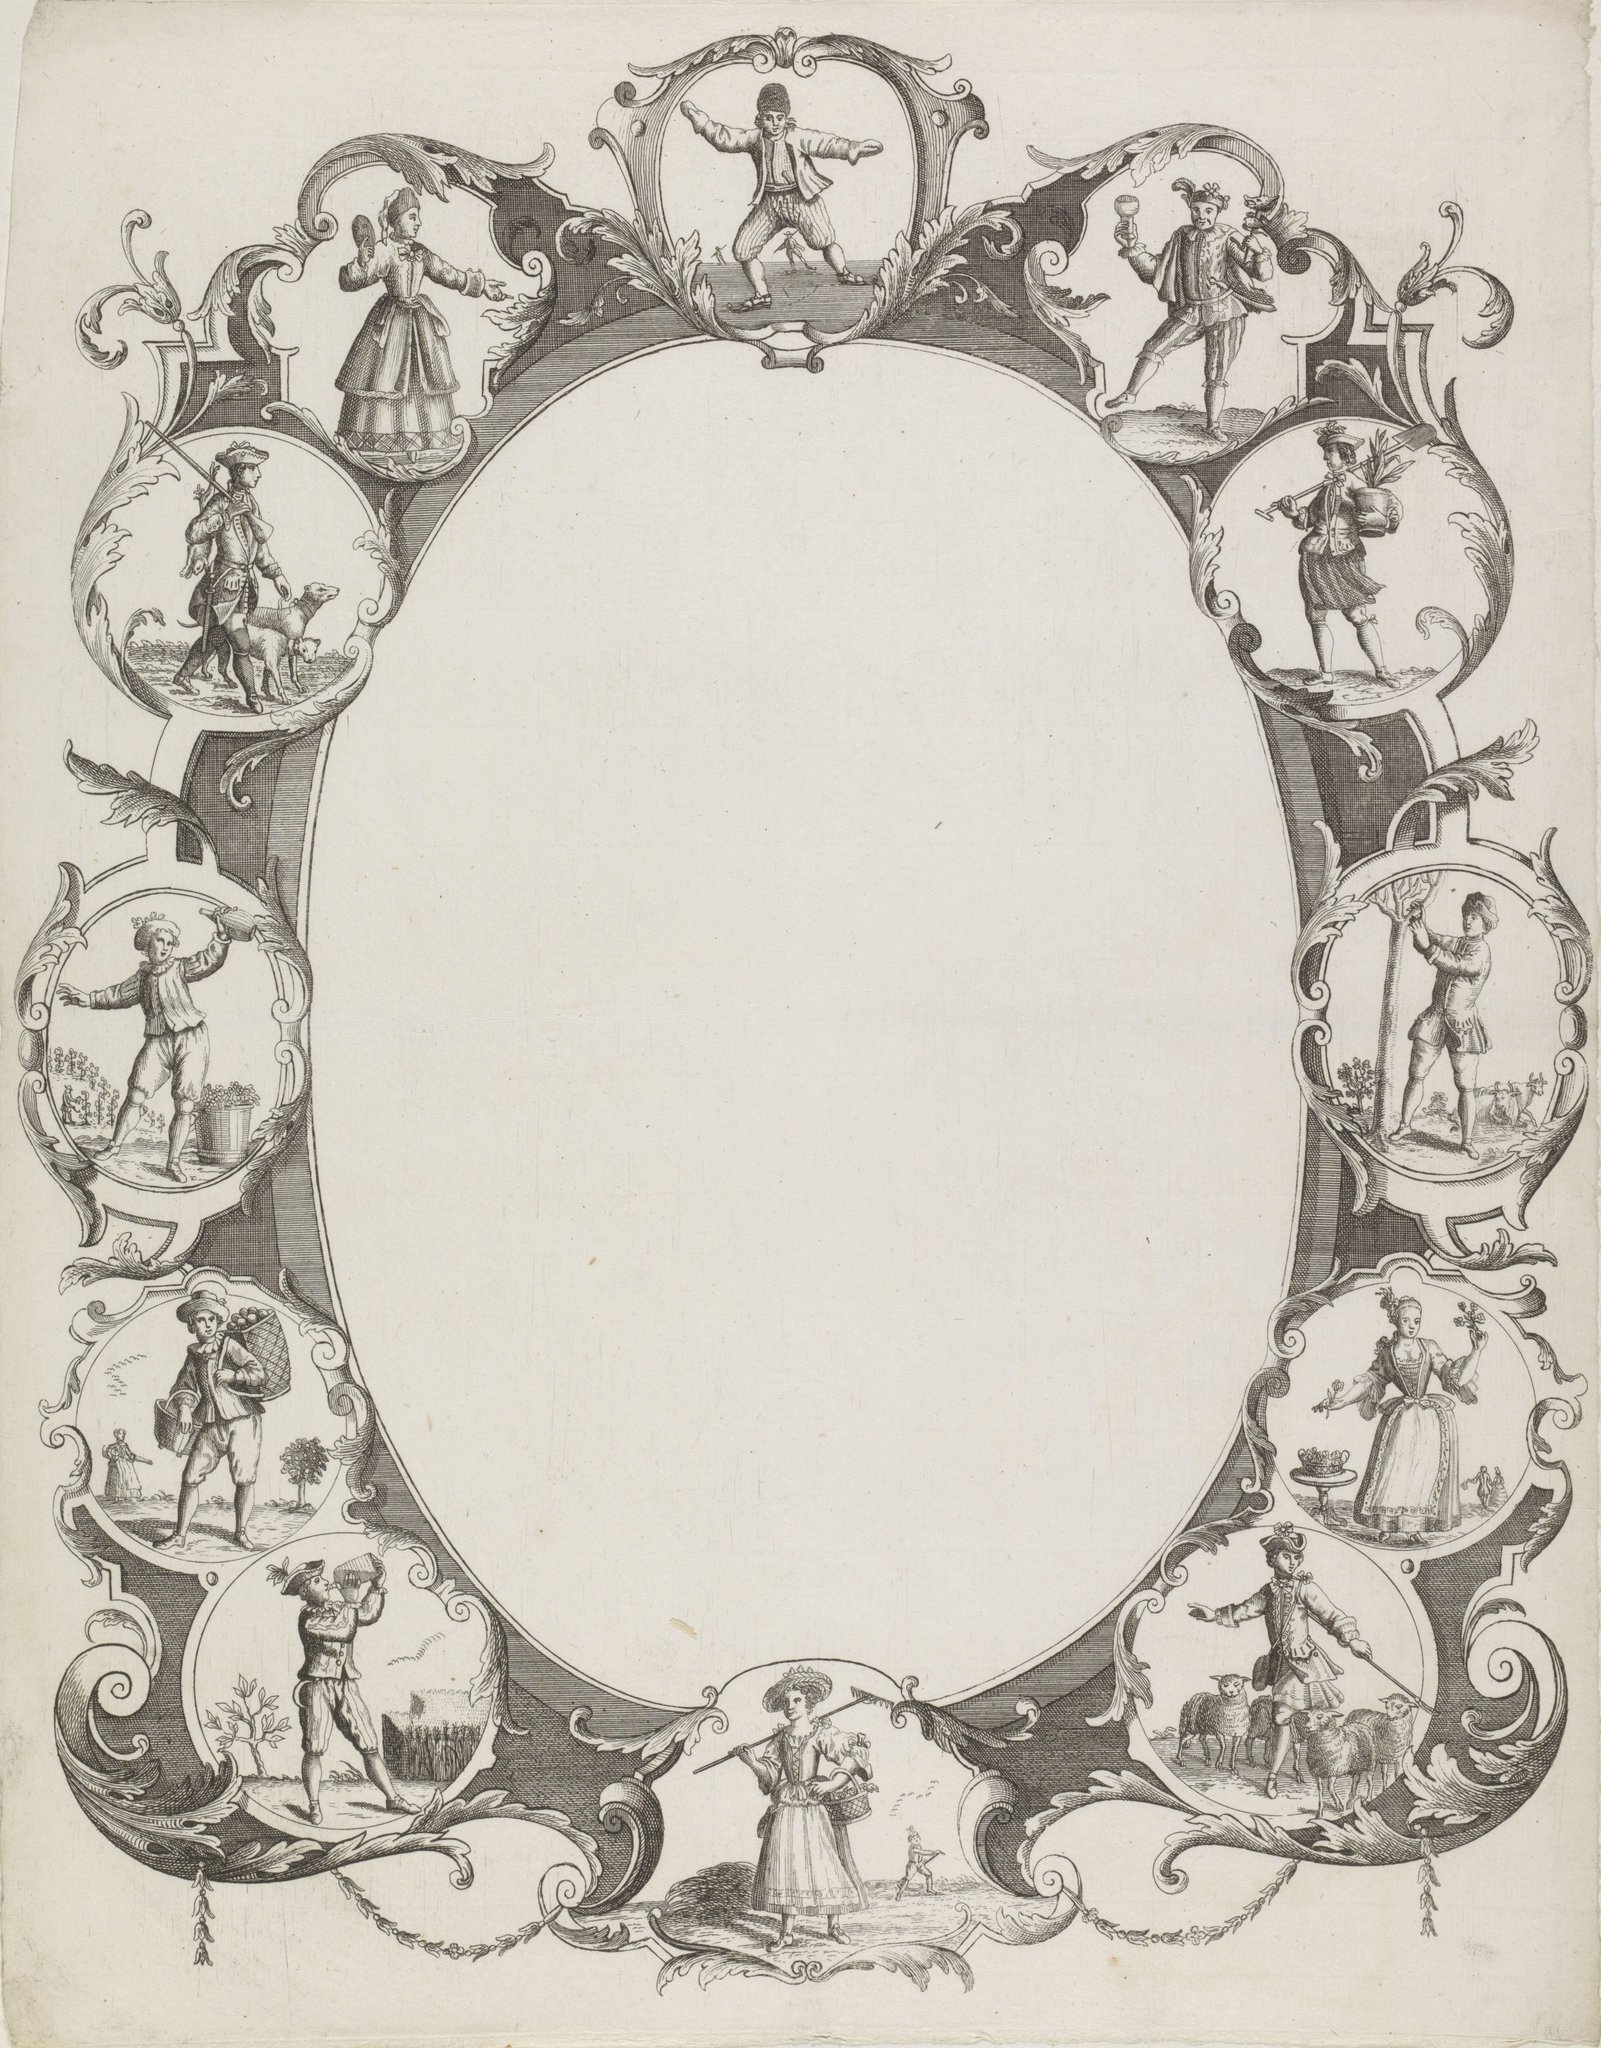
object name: popular print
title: Wensbrief met twaalf maanden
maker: Anonymous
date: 1700-1899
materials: paper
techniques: etching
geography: netherlands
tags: the twelve months (especially personifications); 'mese in generale' (ripa)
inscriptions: collector's mark: Lugt 2760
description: Wensbrief met onbeschreven cartouche binnen een decoratief kader met personificaties van de twaalf maanden van het jaar.